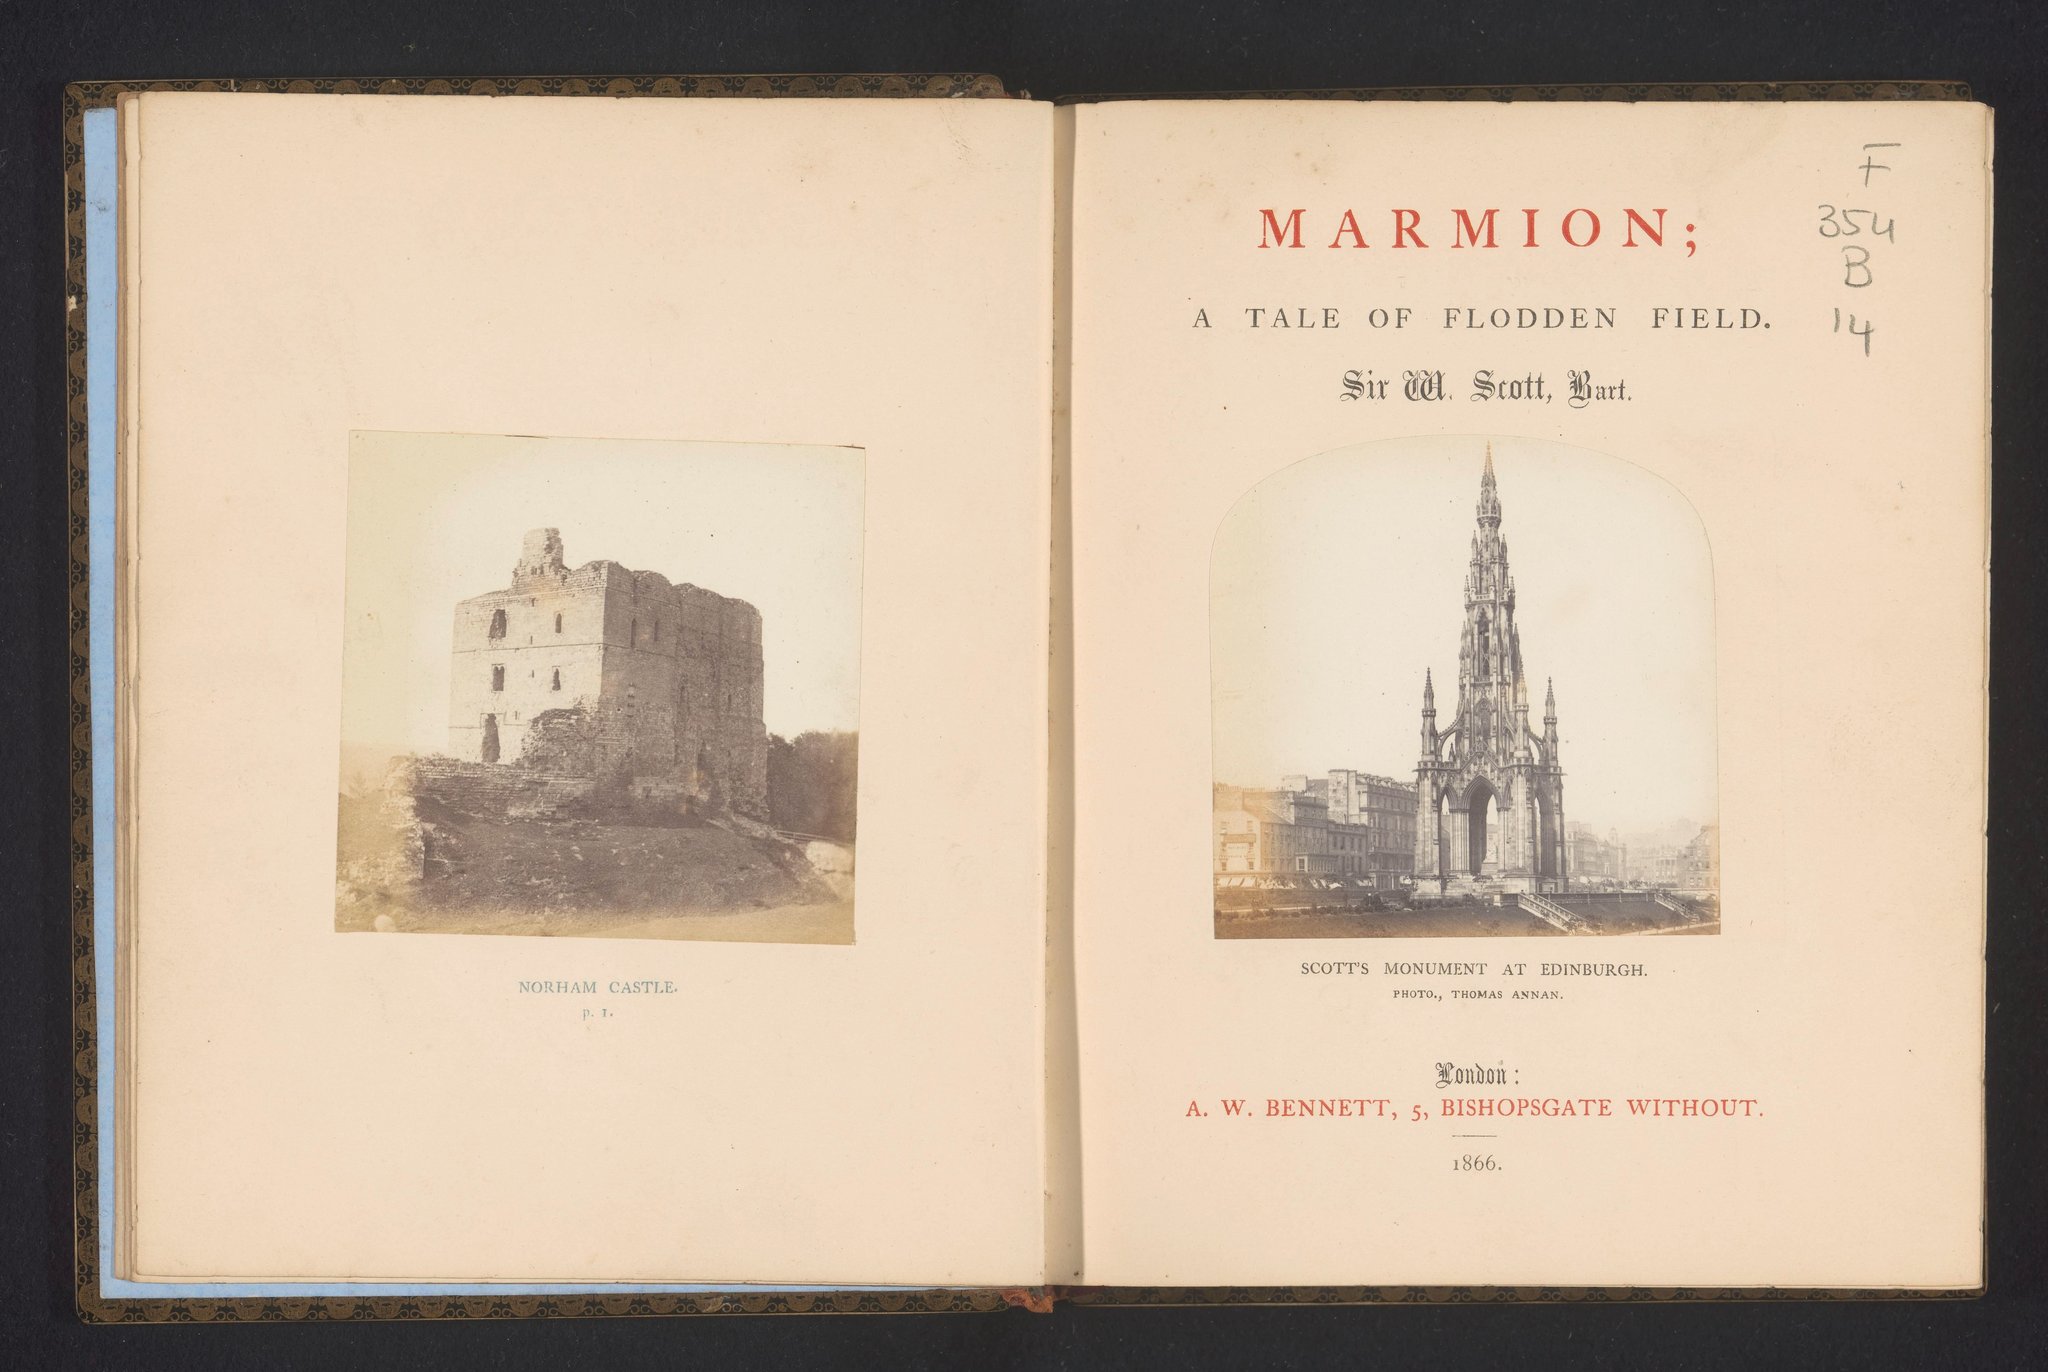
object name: photograph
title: Scott's Monument at Edinburgh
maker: thomas annan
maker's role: fotograaf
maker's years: 1829-1887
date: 1856-1866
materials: photographic support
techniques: albumen print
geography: edinburgh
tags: monument, statue, parts of church exterior and annexes: spire